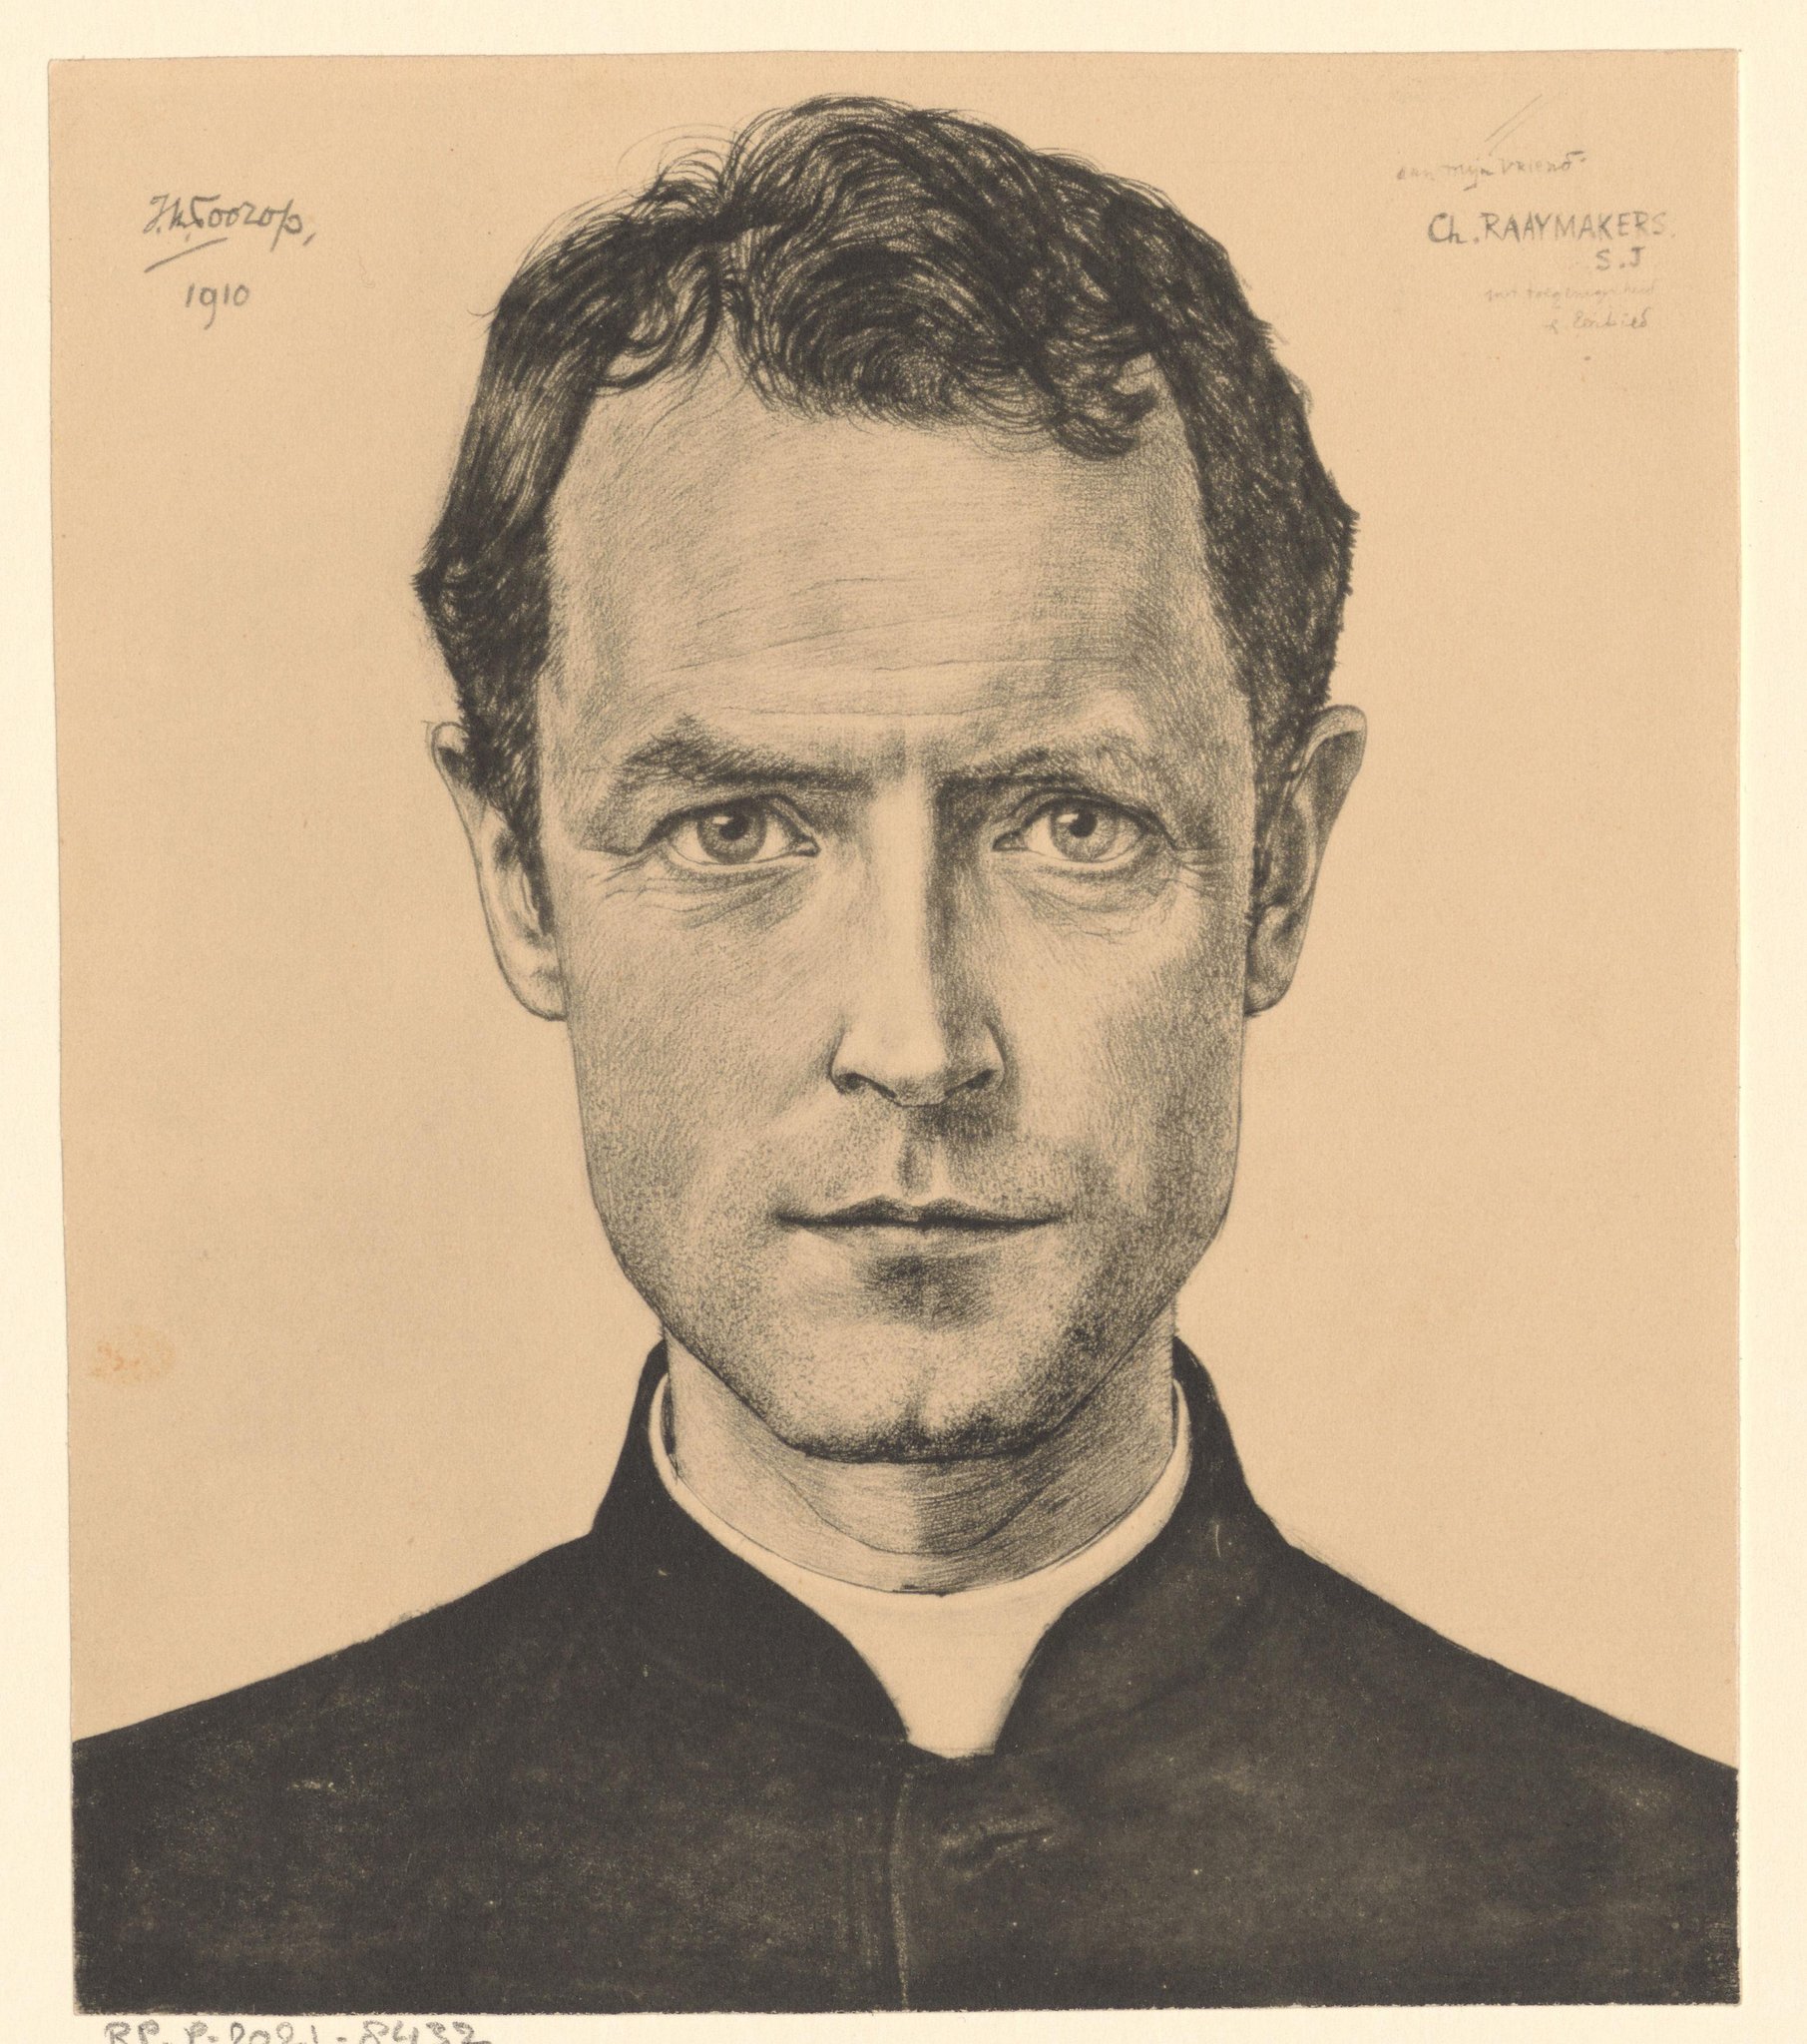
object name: photomechanical print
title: Portret van Charles Raaijmakers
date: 1910-1930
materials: paper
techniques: photograph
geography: netherlands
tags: nijmegen, priest, historical persons